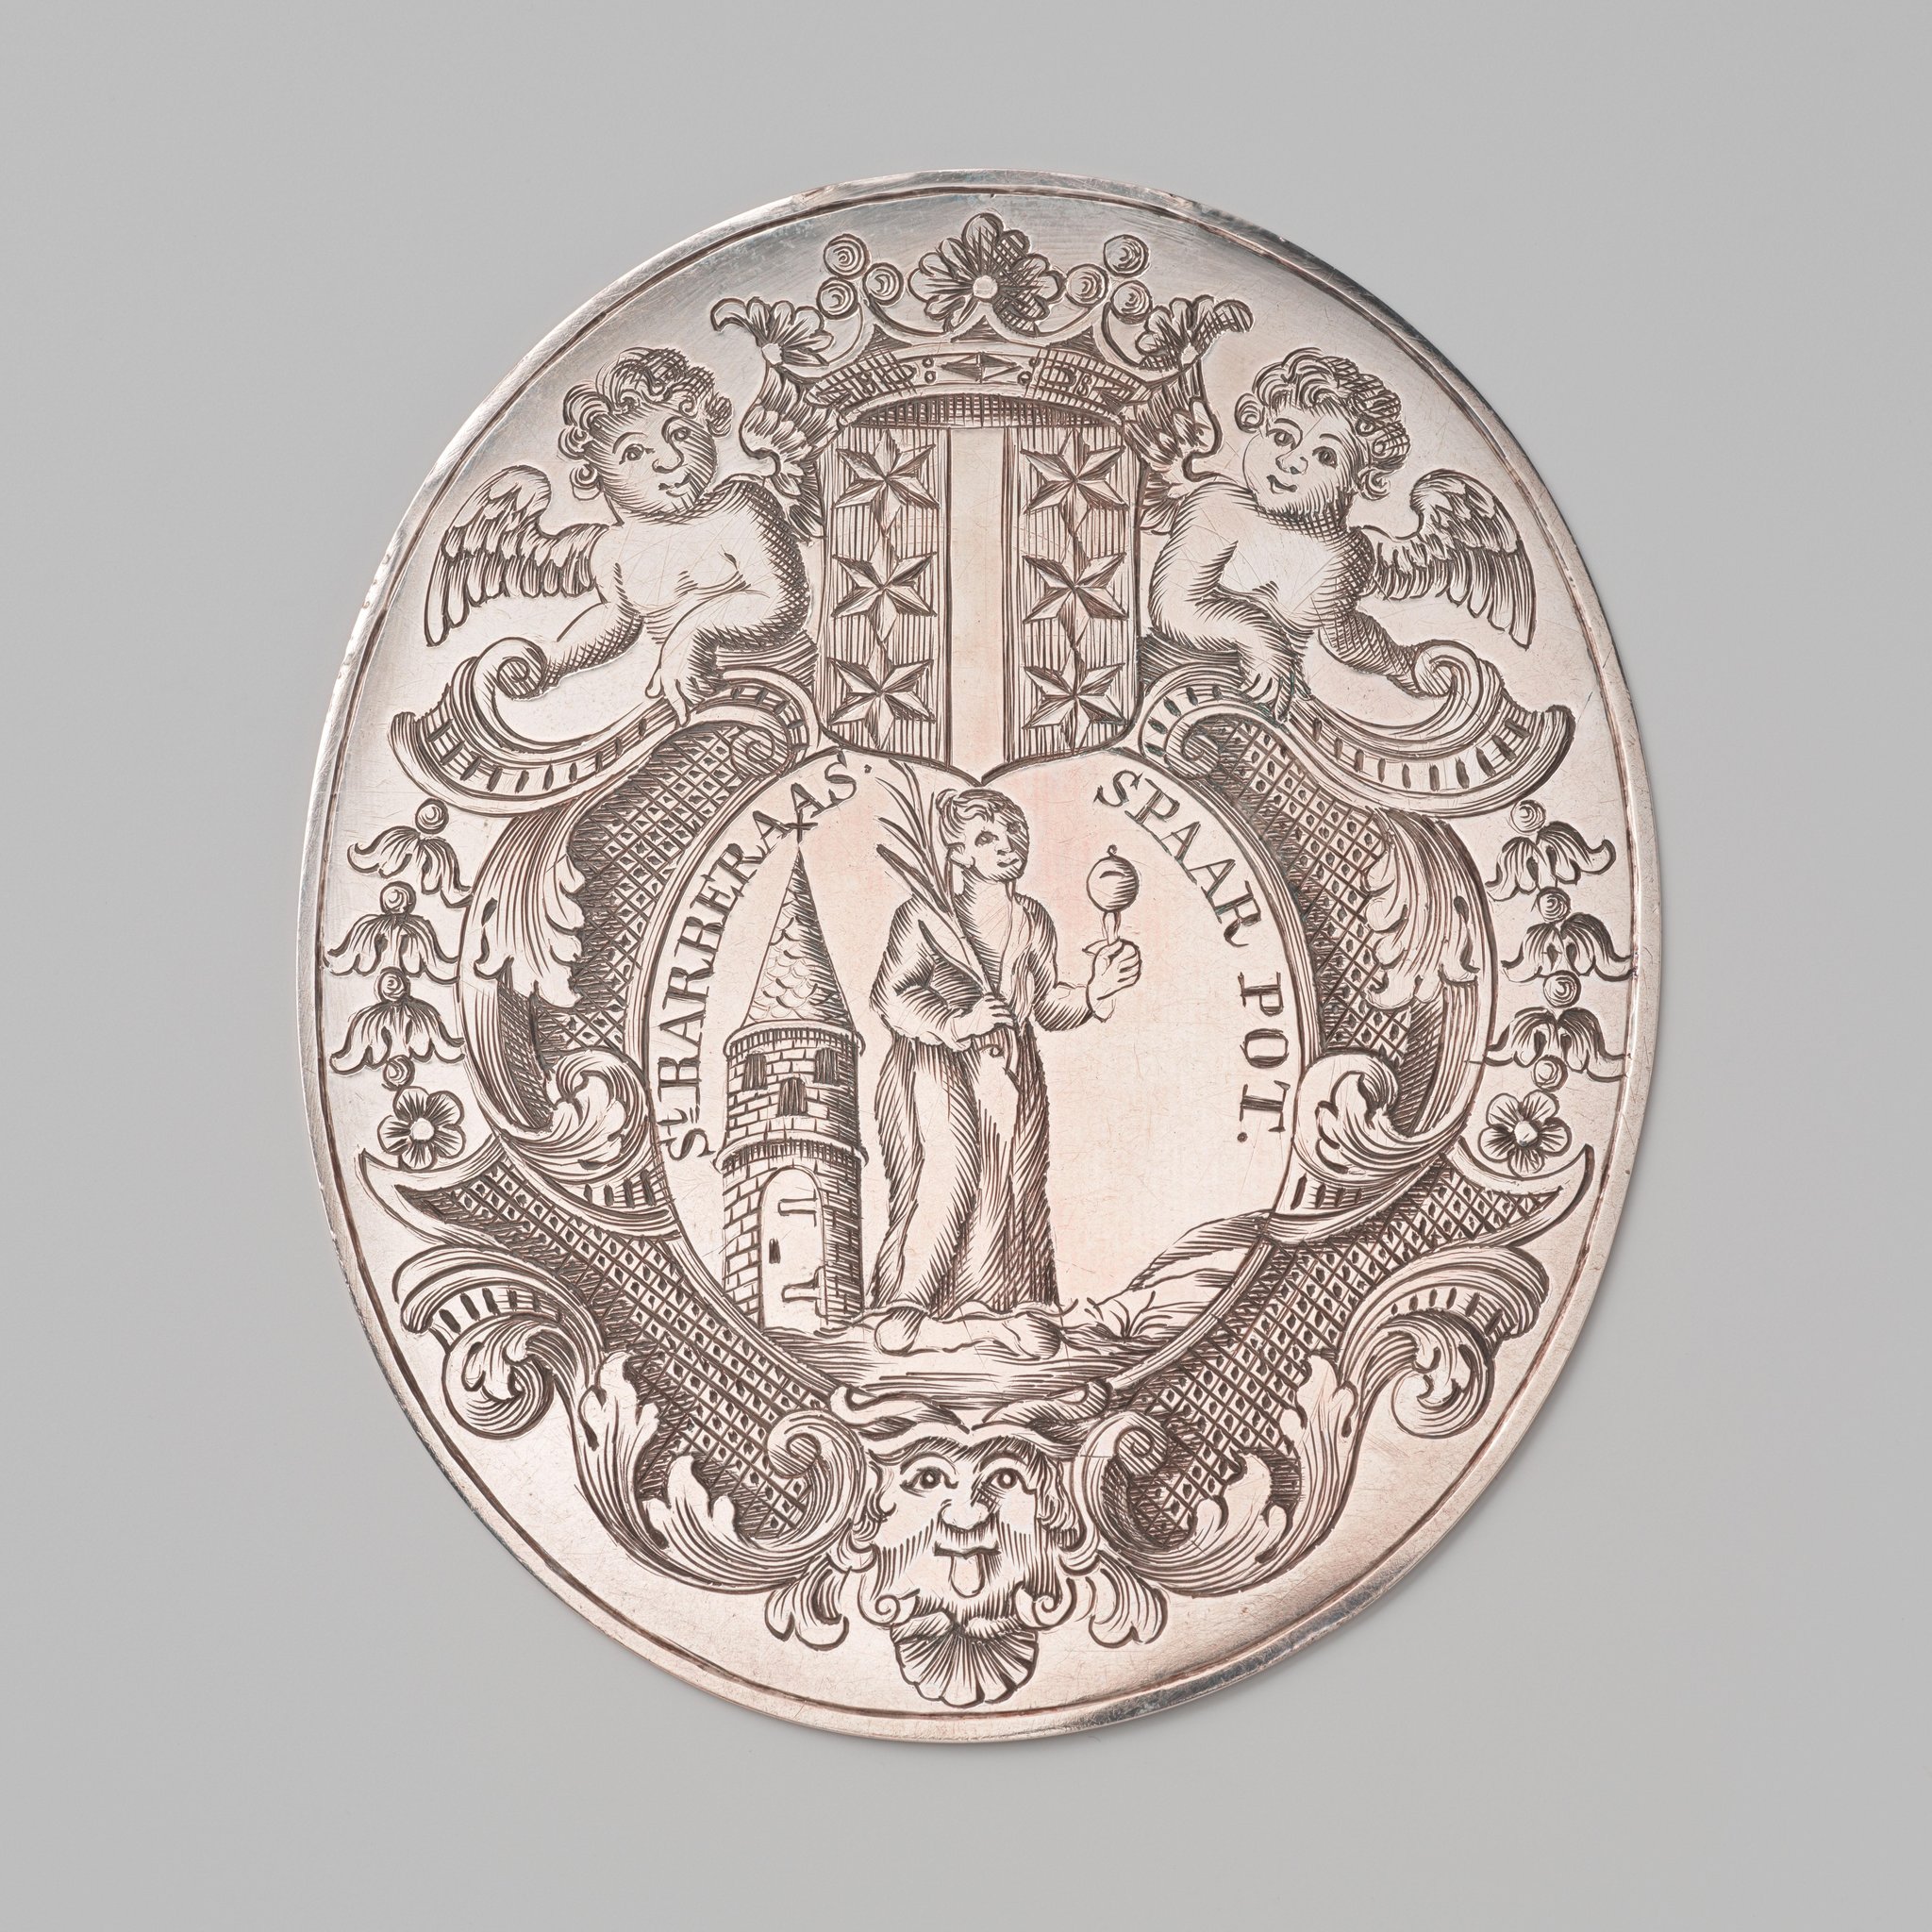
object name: plaque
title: Sint Barbara's Spaarpot te Gouda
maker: Anonymous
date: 1775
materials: metal, silver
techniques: engraving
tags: the virgin martyr barbara; possible attributes: book, cannon(ball), crown, cross, chalice with wafer, dioscuros (her father), peacock feather, sword, torches, mason's tools, tower, gouda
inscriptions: inscription: ‘ANNO 1775 / JAN . LUGTHART . / JAN . VAN BENTUM . / JACOP . VAN BENTUM . / CORNELIS . SORG . / WOUTER . BYL .’, circumscription: ‘St- BARBERAAS . - SPAAR POT .’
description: Zilveren gegraveerde plaquette. Voorzijde: in cartouche, van boven afgesloten door gekroond wapenschild van Gouda, de heilige Barbara naar links gewend, met in linkerhand een spaarpot en in rechterhand een palmtak. Aan haar rechterzijde de Barbaratoren. Opschrift in kapitalen ingegraveerd. Te weerszijden van het wapen putti en onderaan de cartouche een gezicht. Keerzijde: kroon, kannen, kandelaar en spaarpot